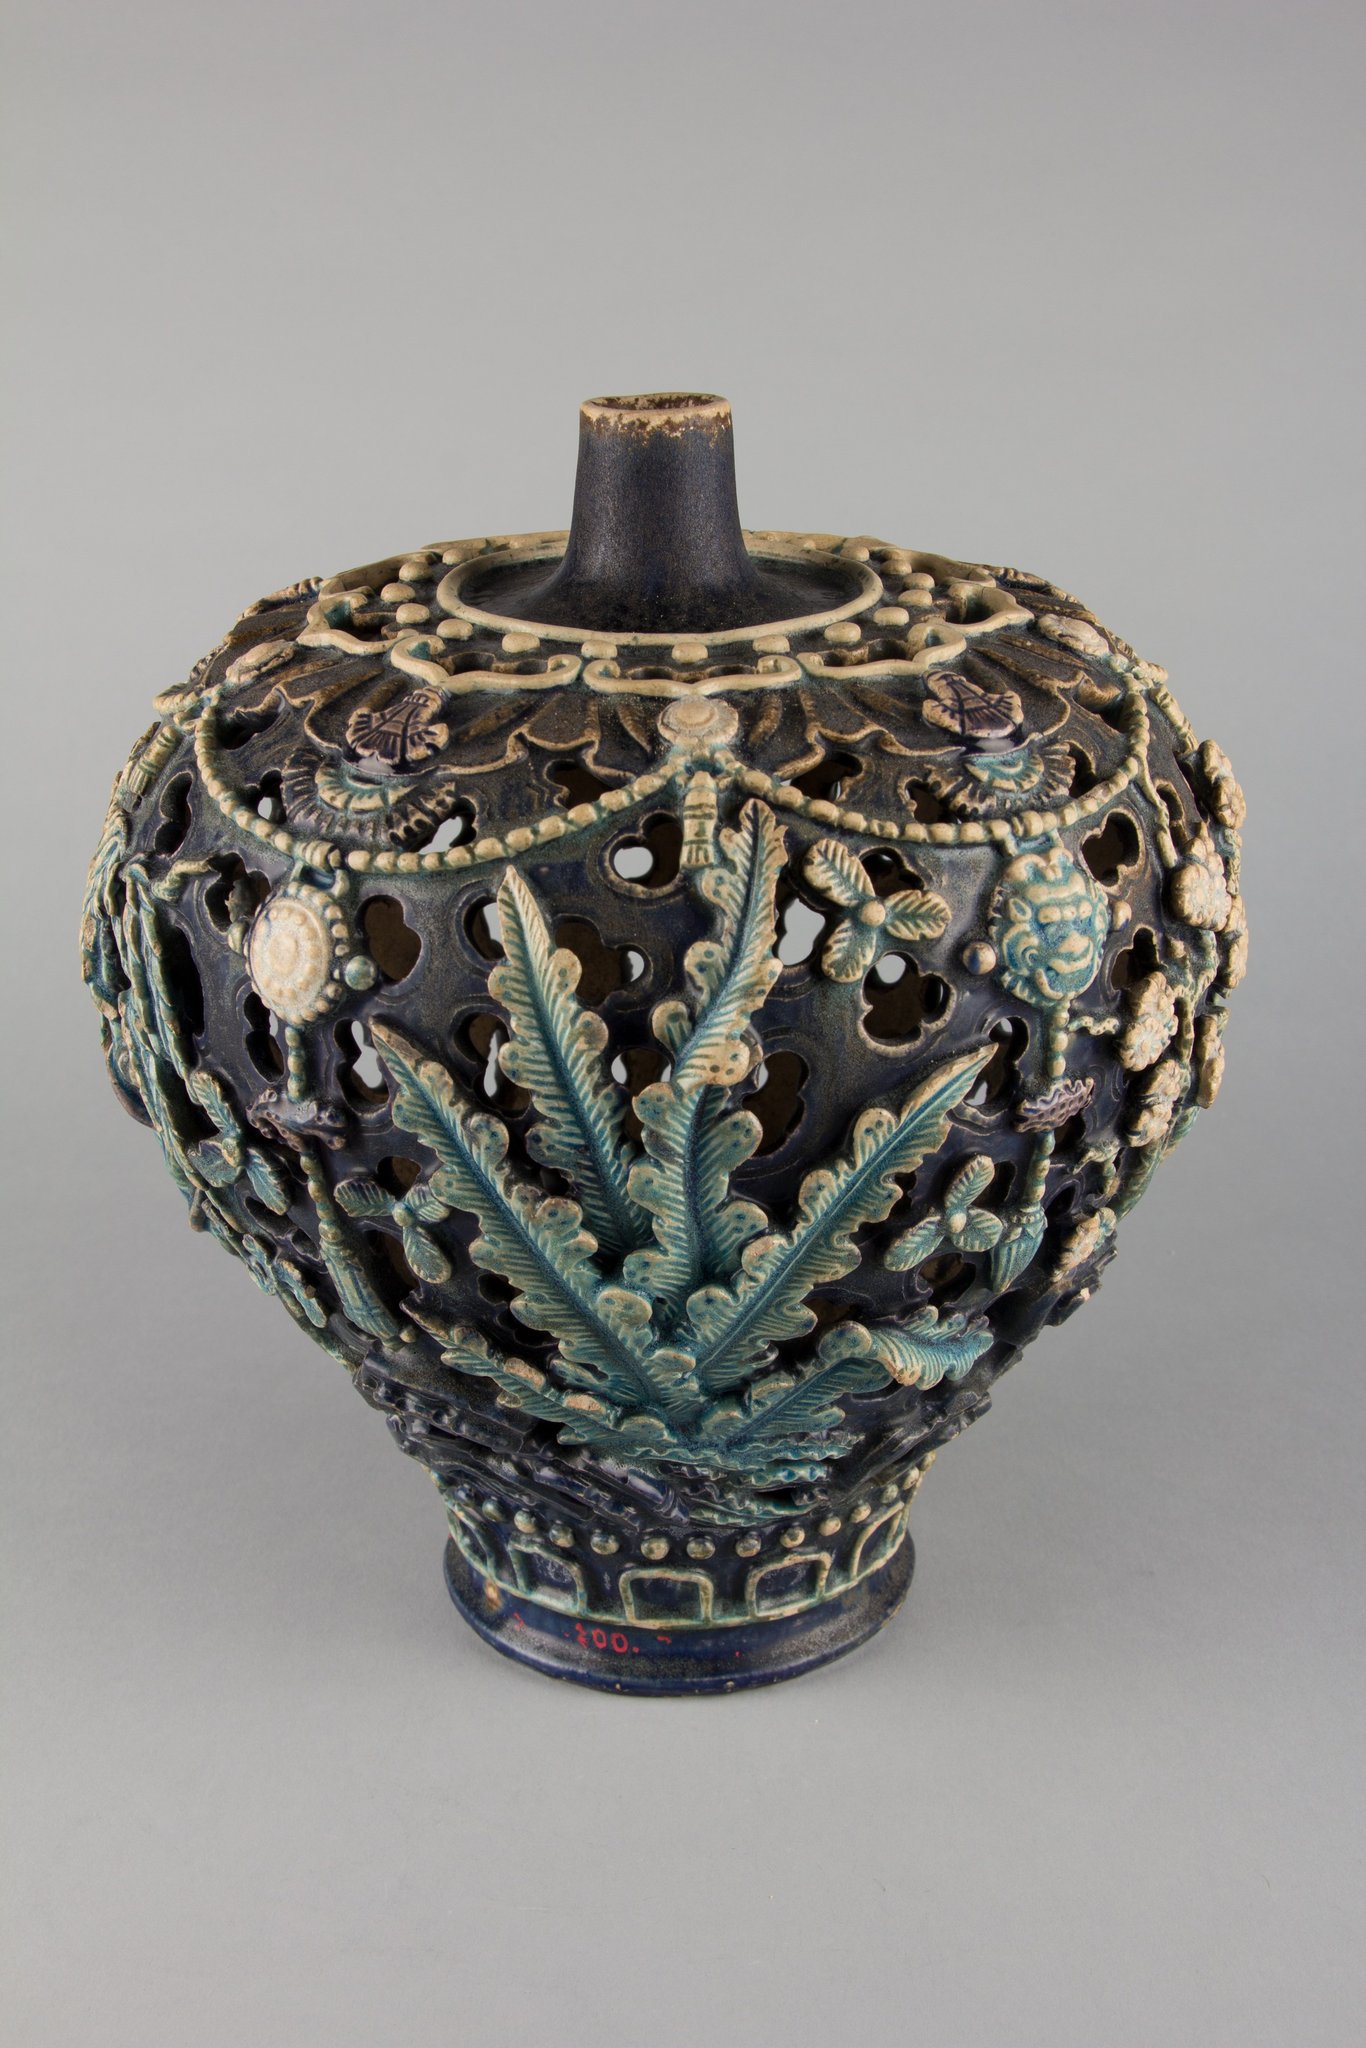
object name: vase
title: Openwork vase with plants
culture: chinese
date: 1467-1533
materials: glaze, stoneware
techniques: polychrome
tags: leaves